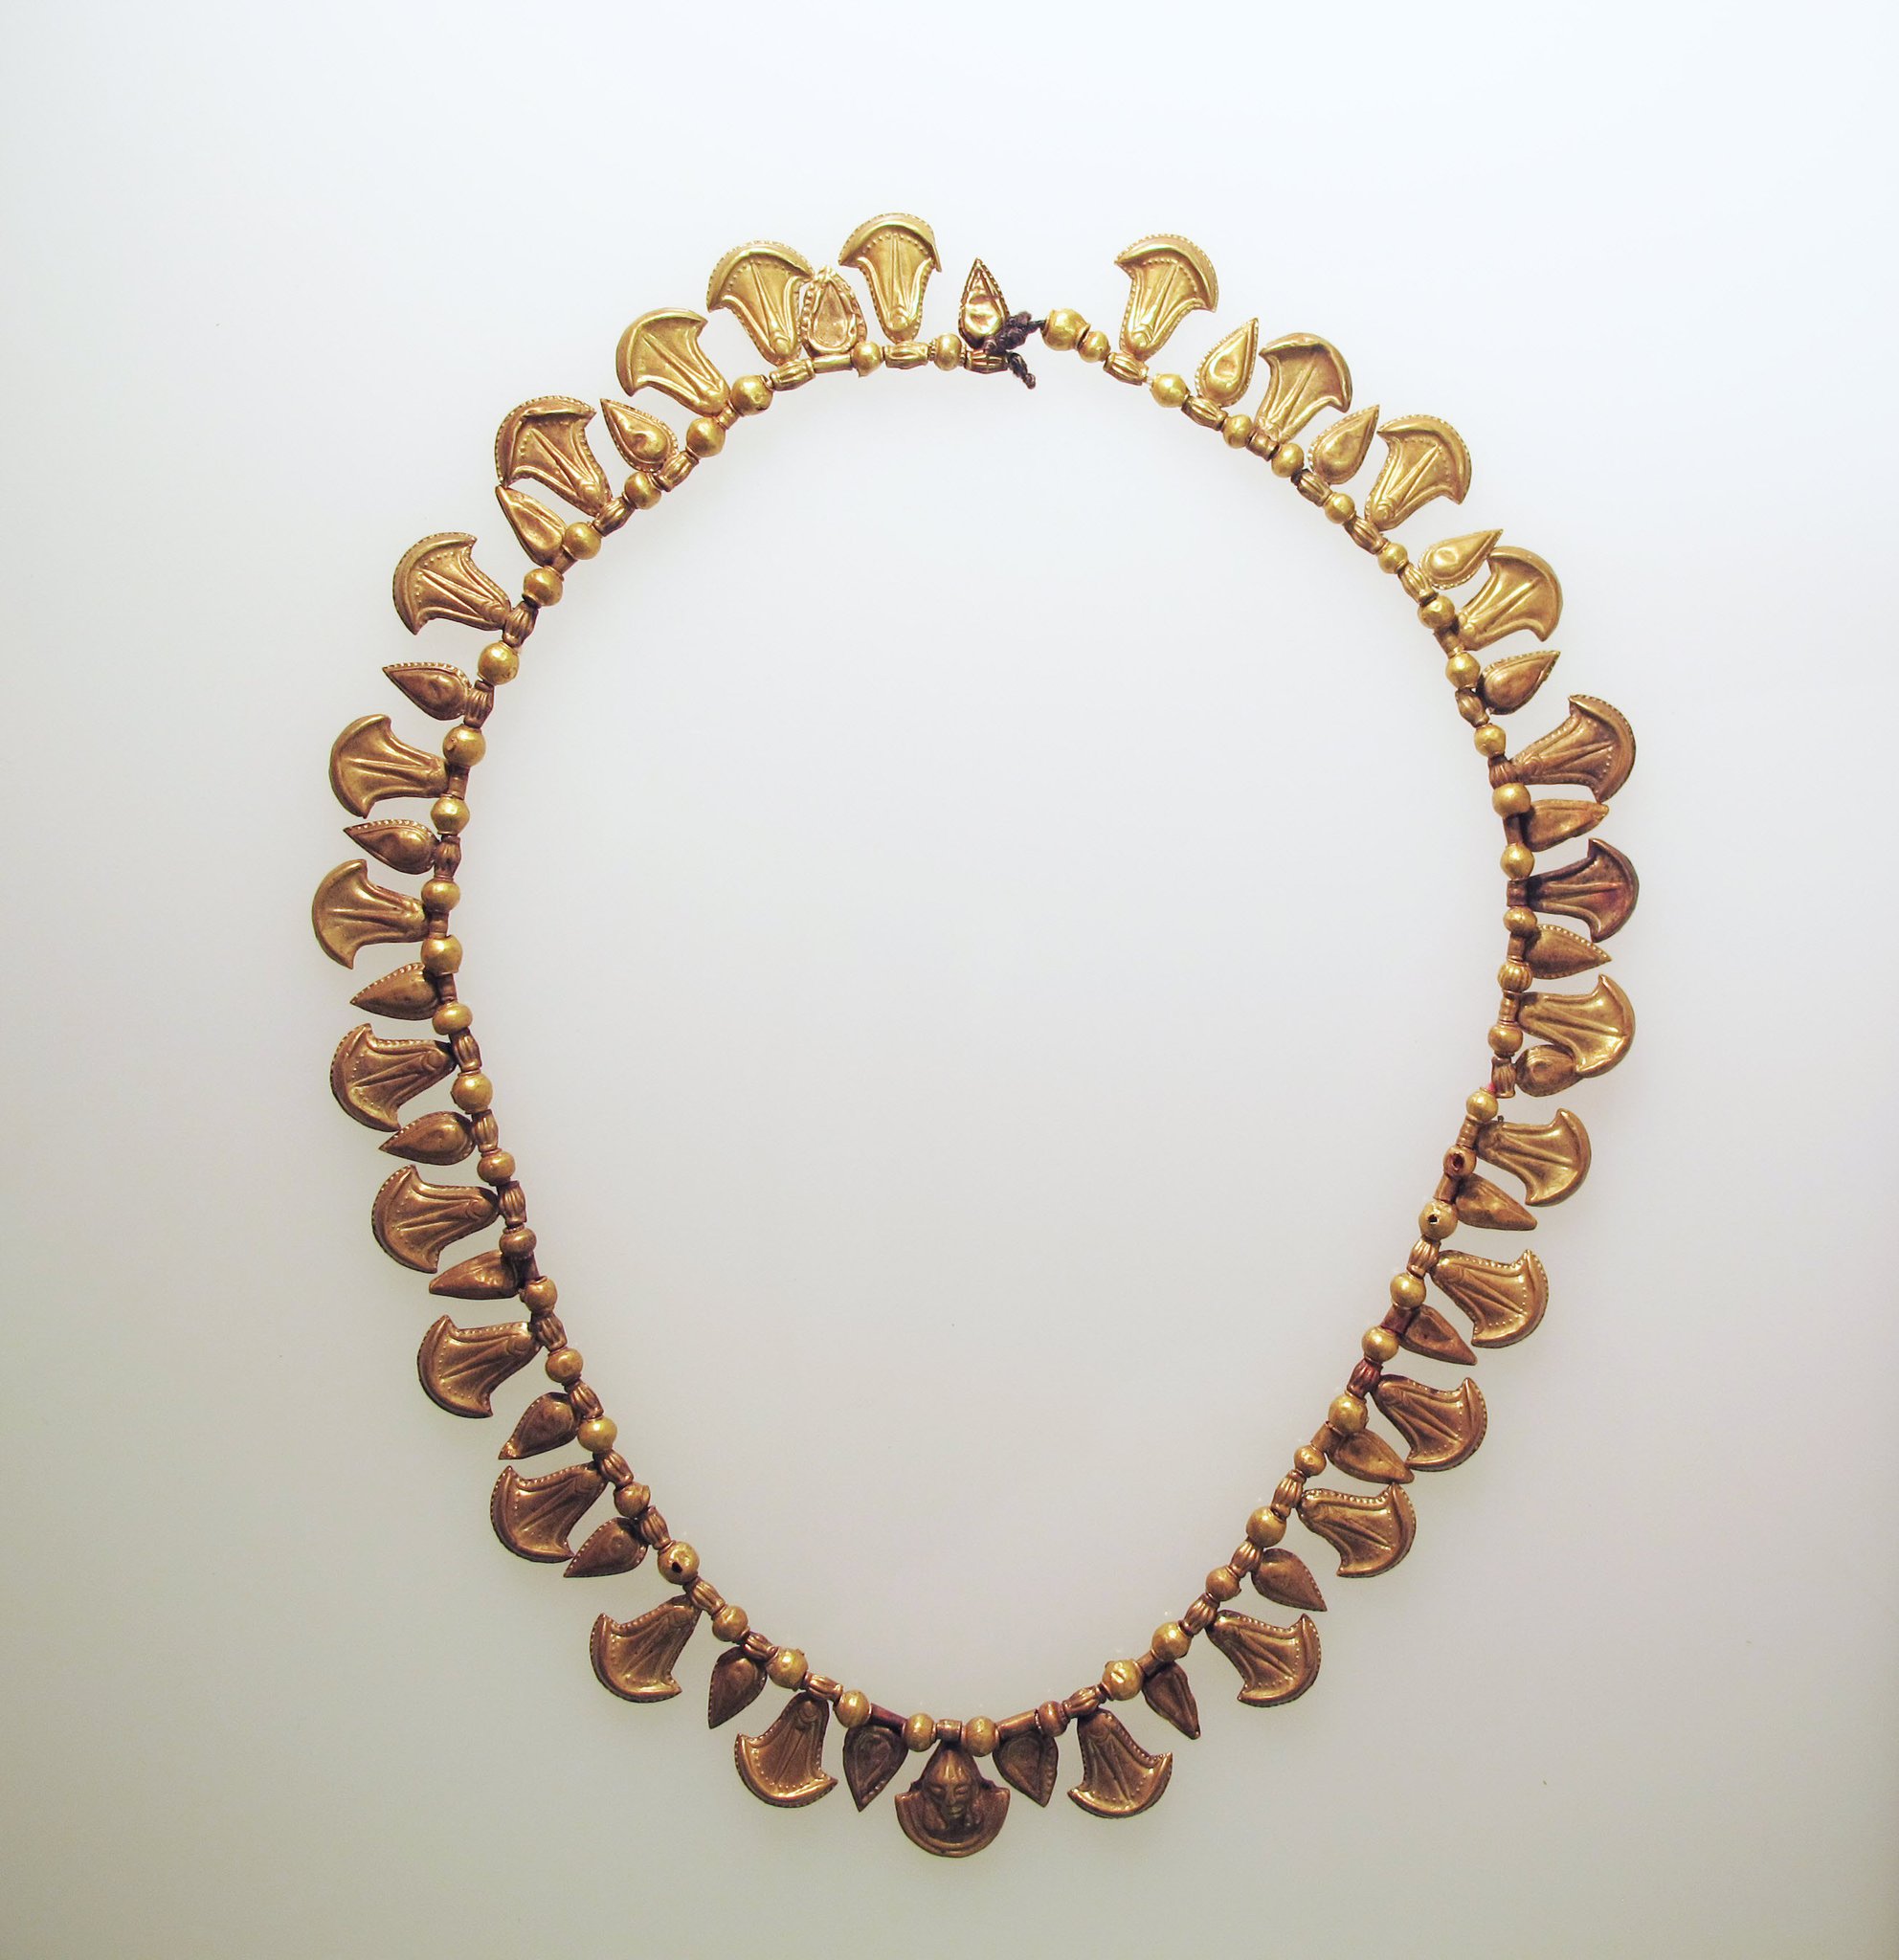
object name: bead pendant, with lotus flower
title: Bead pendant, with lotus flowers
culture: cypriot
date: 3900 BCE-100 CE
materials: gold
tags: lotuses